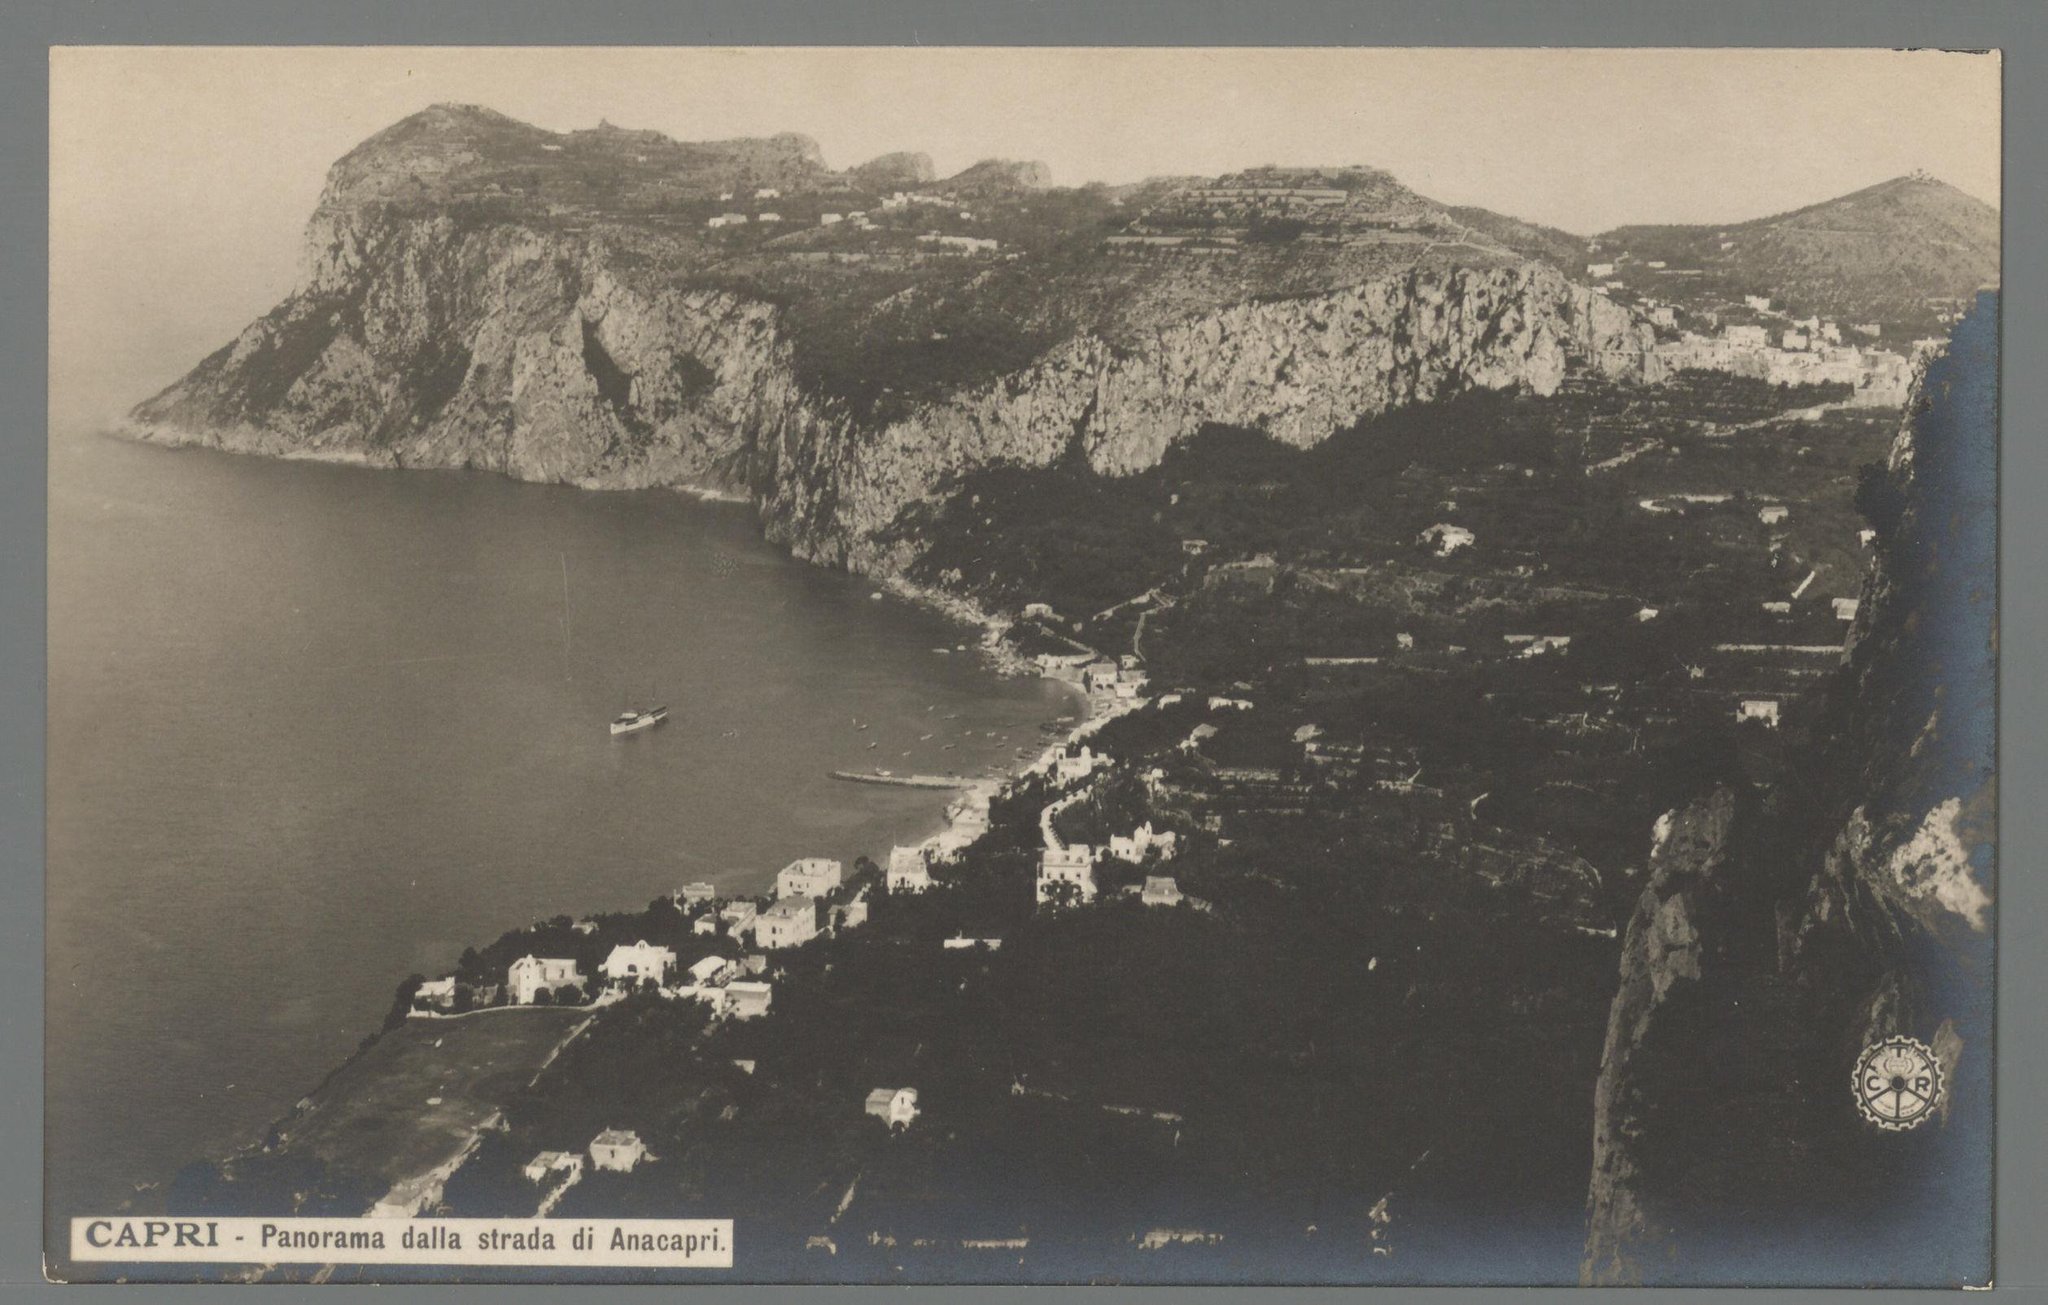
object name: photograph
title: Capri. Panorama della Strada di Anacapri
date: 1889-1906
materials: paper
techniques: gelatin silver print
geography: milan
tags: rocky coast, landscapes with waters, waterscapes, seascapes (in the temperate zone), capri, isola di